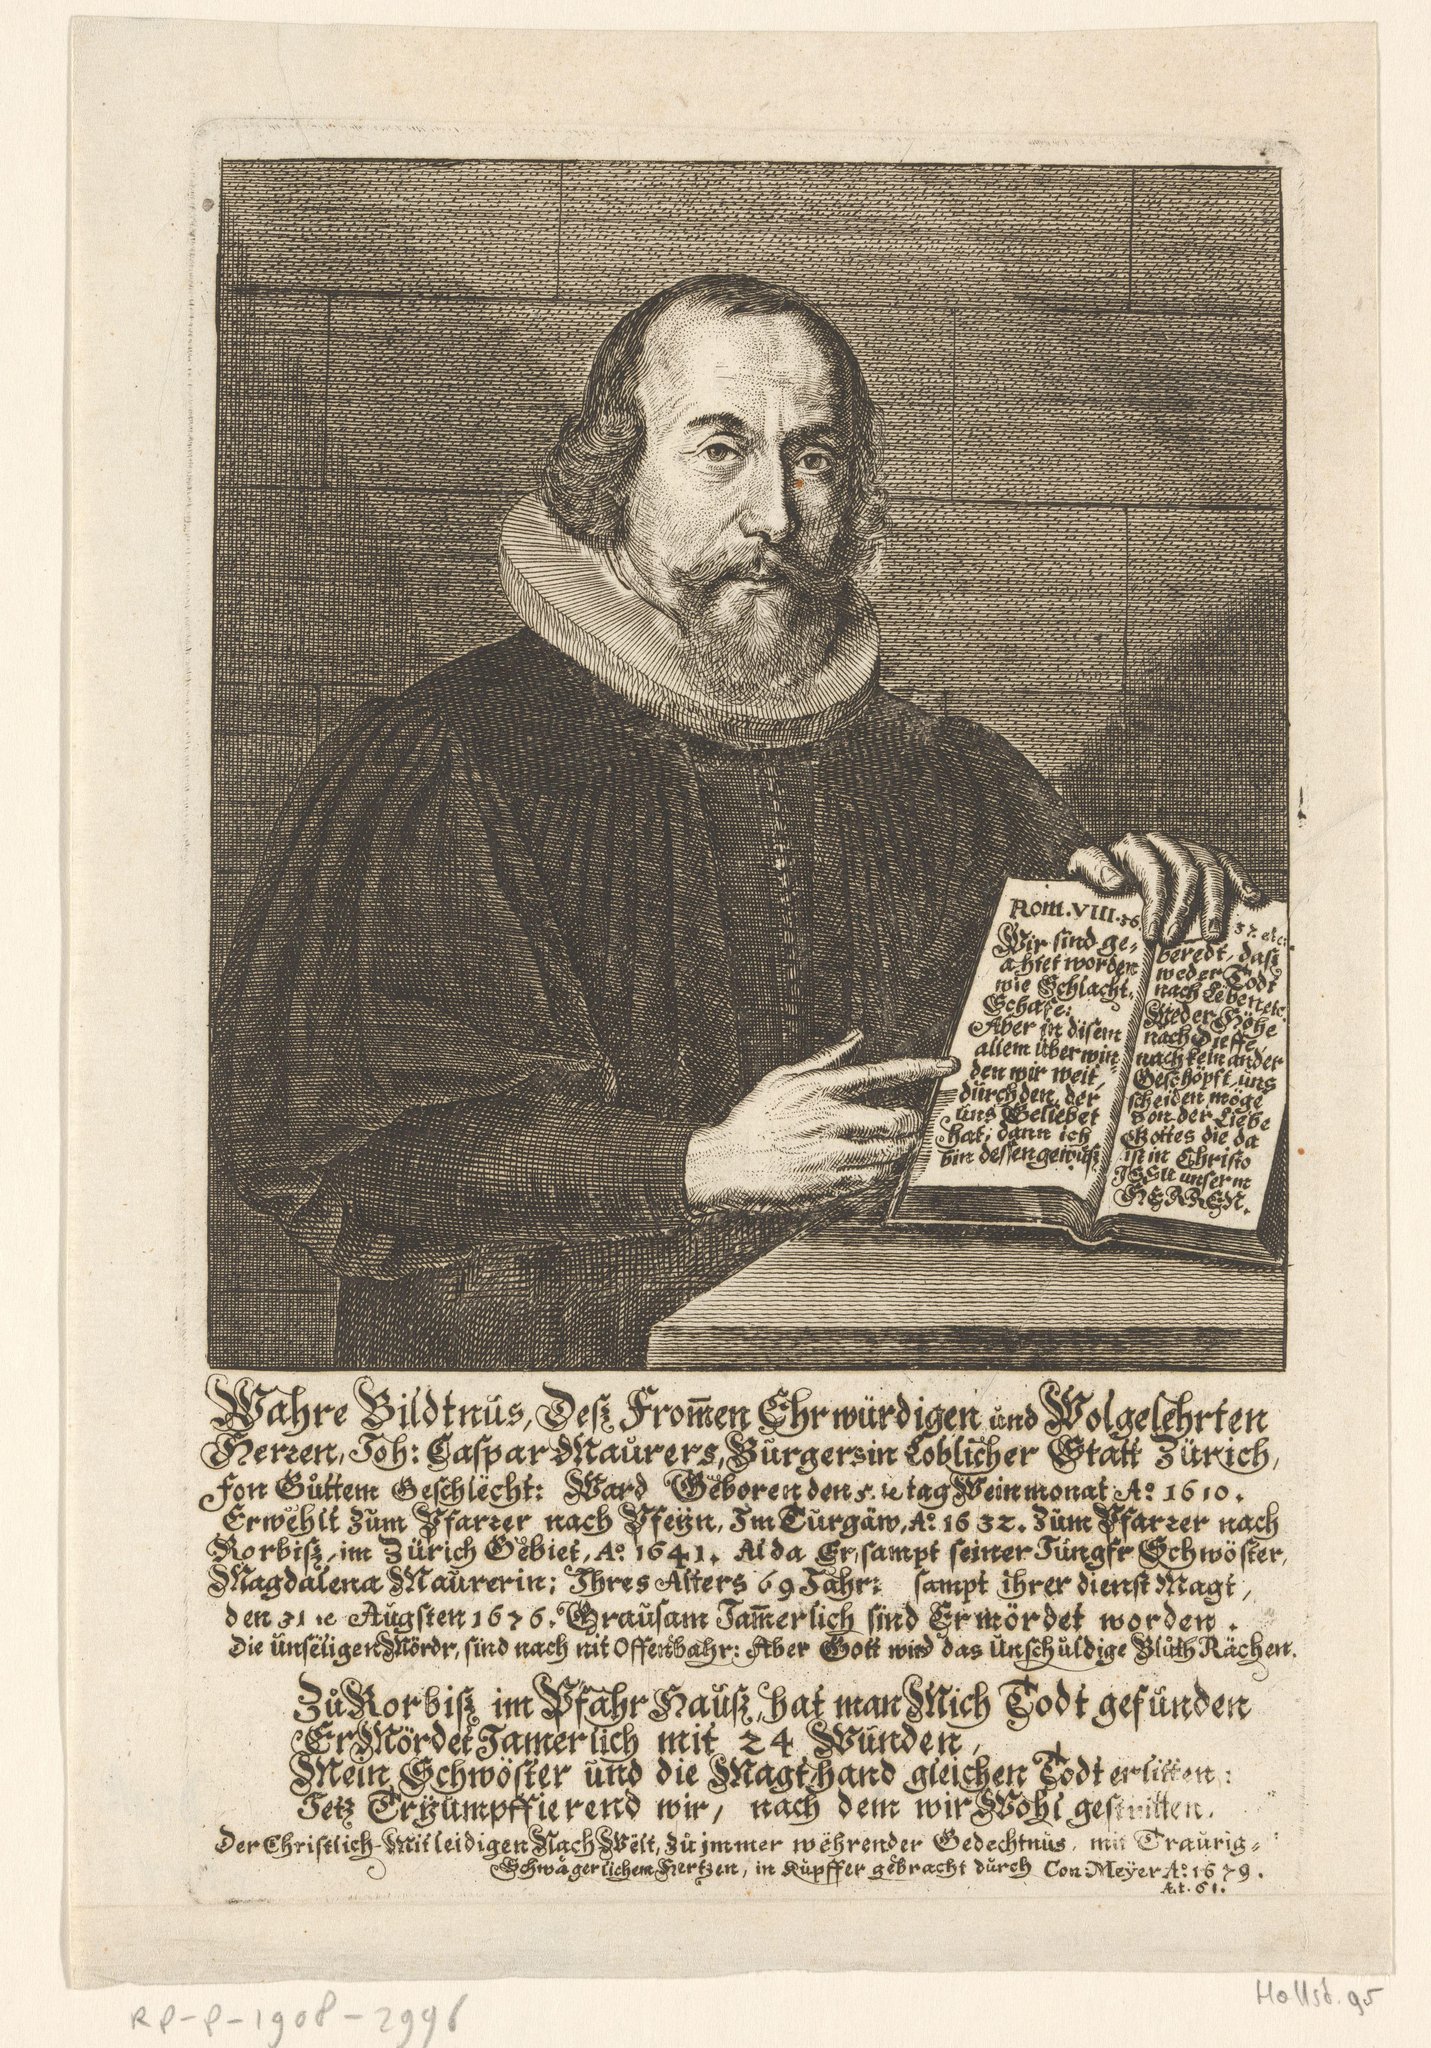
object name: print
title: Portret van Johann Caspar Maurer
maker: conrad meyer (i)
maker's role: painter, print maker, publisher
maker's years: 1618-1689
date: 1679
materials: paper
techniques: engraving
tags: historical persons, book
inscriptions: collector's mark: Lugt 2228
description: Onderdeel van een serie van 62 portretten van priesters en theologen van Zürich. Zie Hollstein German 111, 1-41.